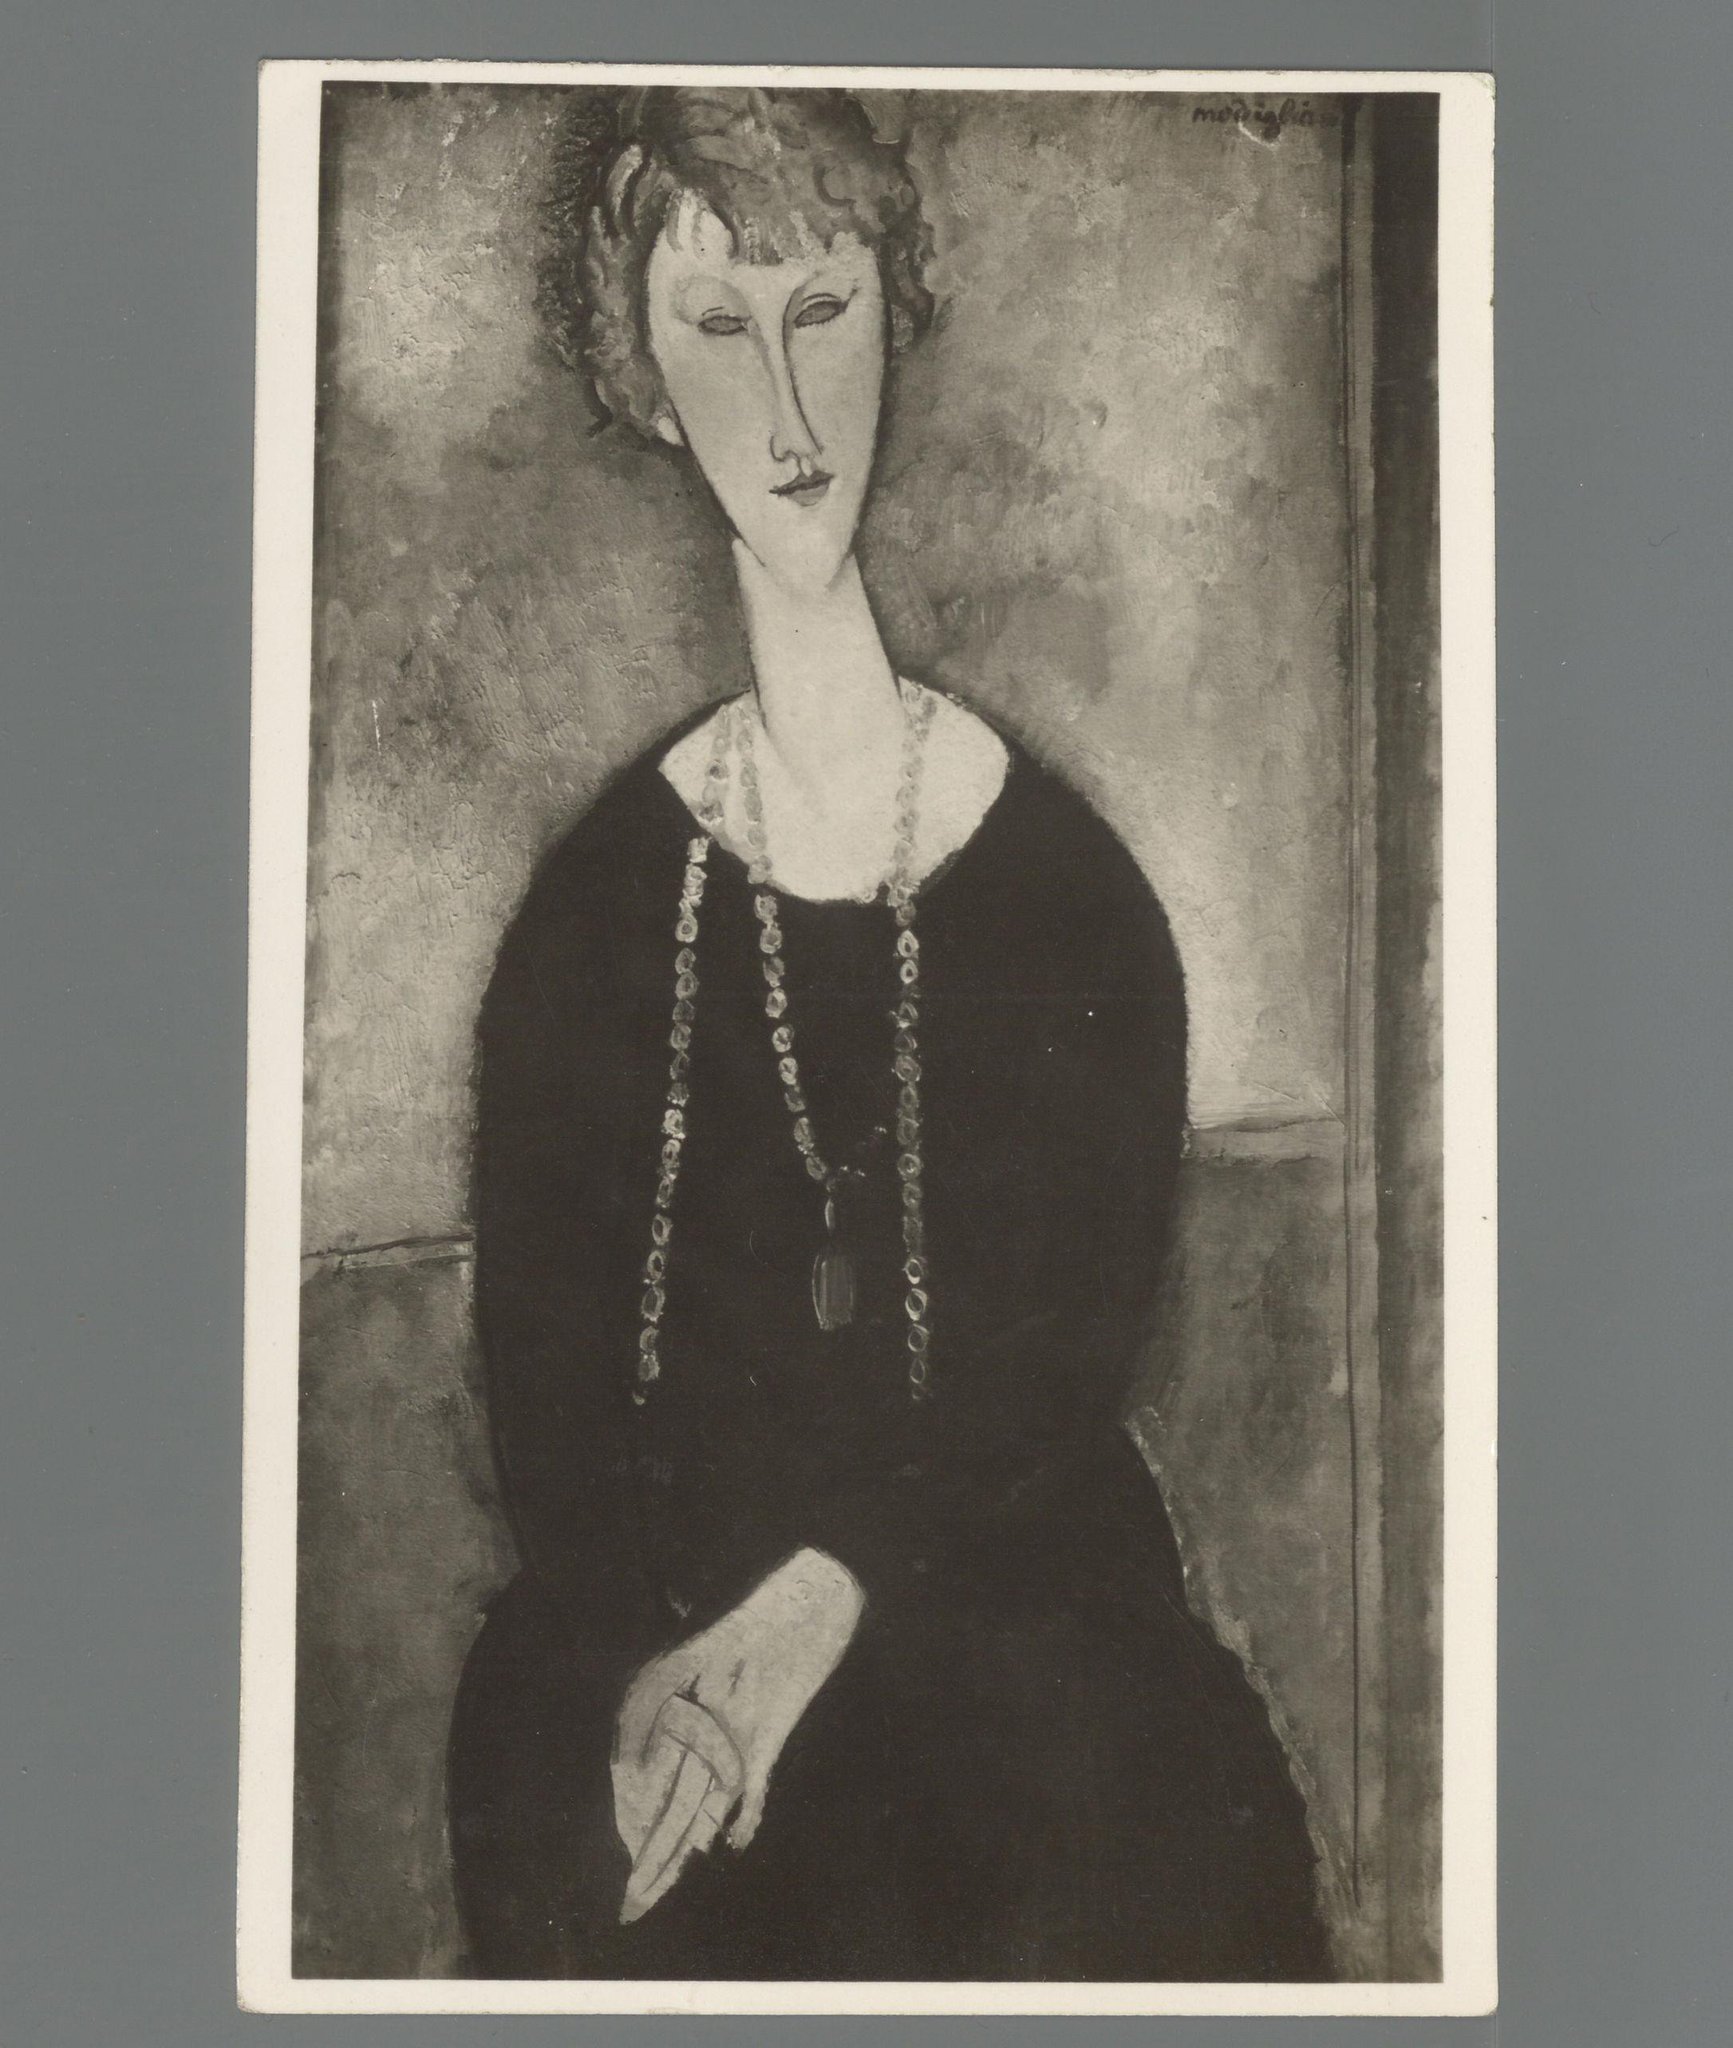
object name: reproduction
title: Amedeo Modigliani. Ritratto di Signora bionda. Coll. Cardazzo. Venezia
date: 1929-1938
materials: photographic support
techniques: photography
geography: venice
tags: adult woman, necklace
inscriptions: postage stamp